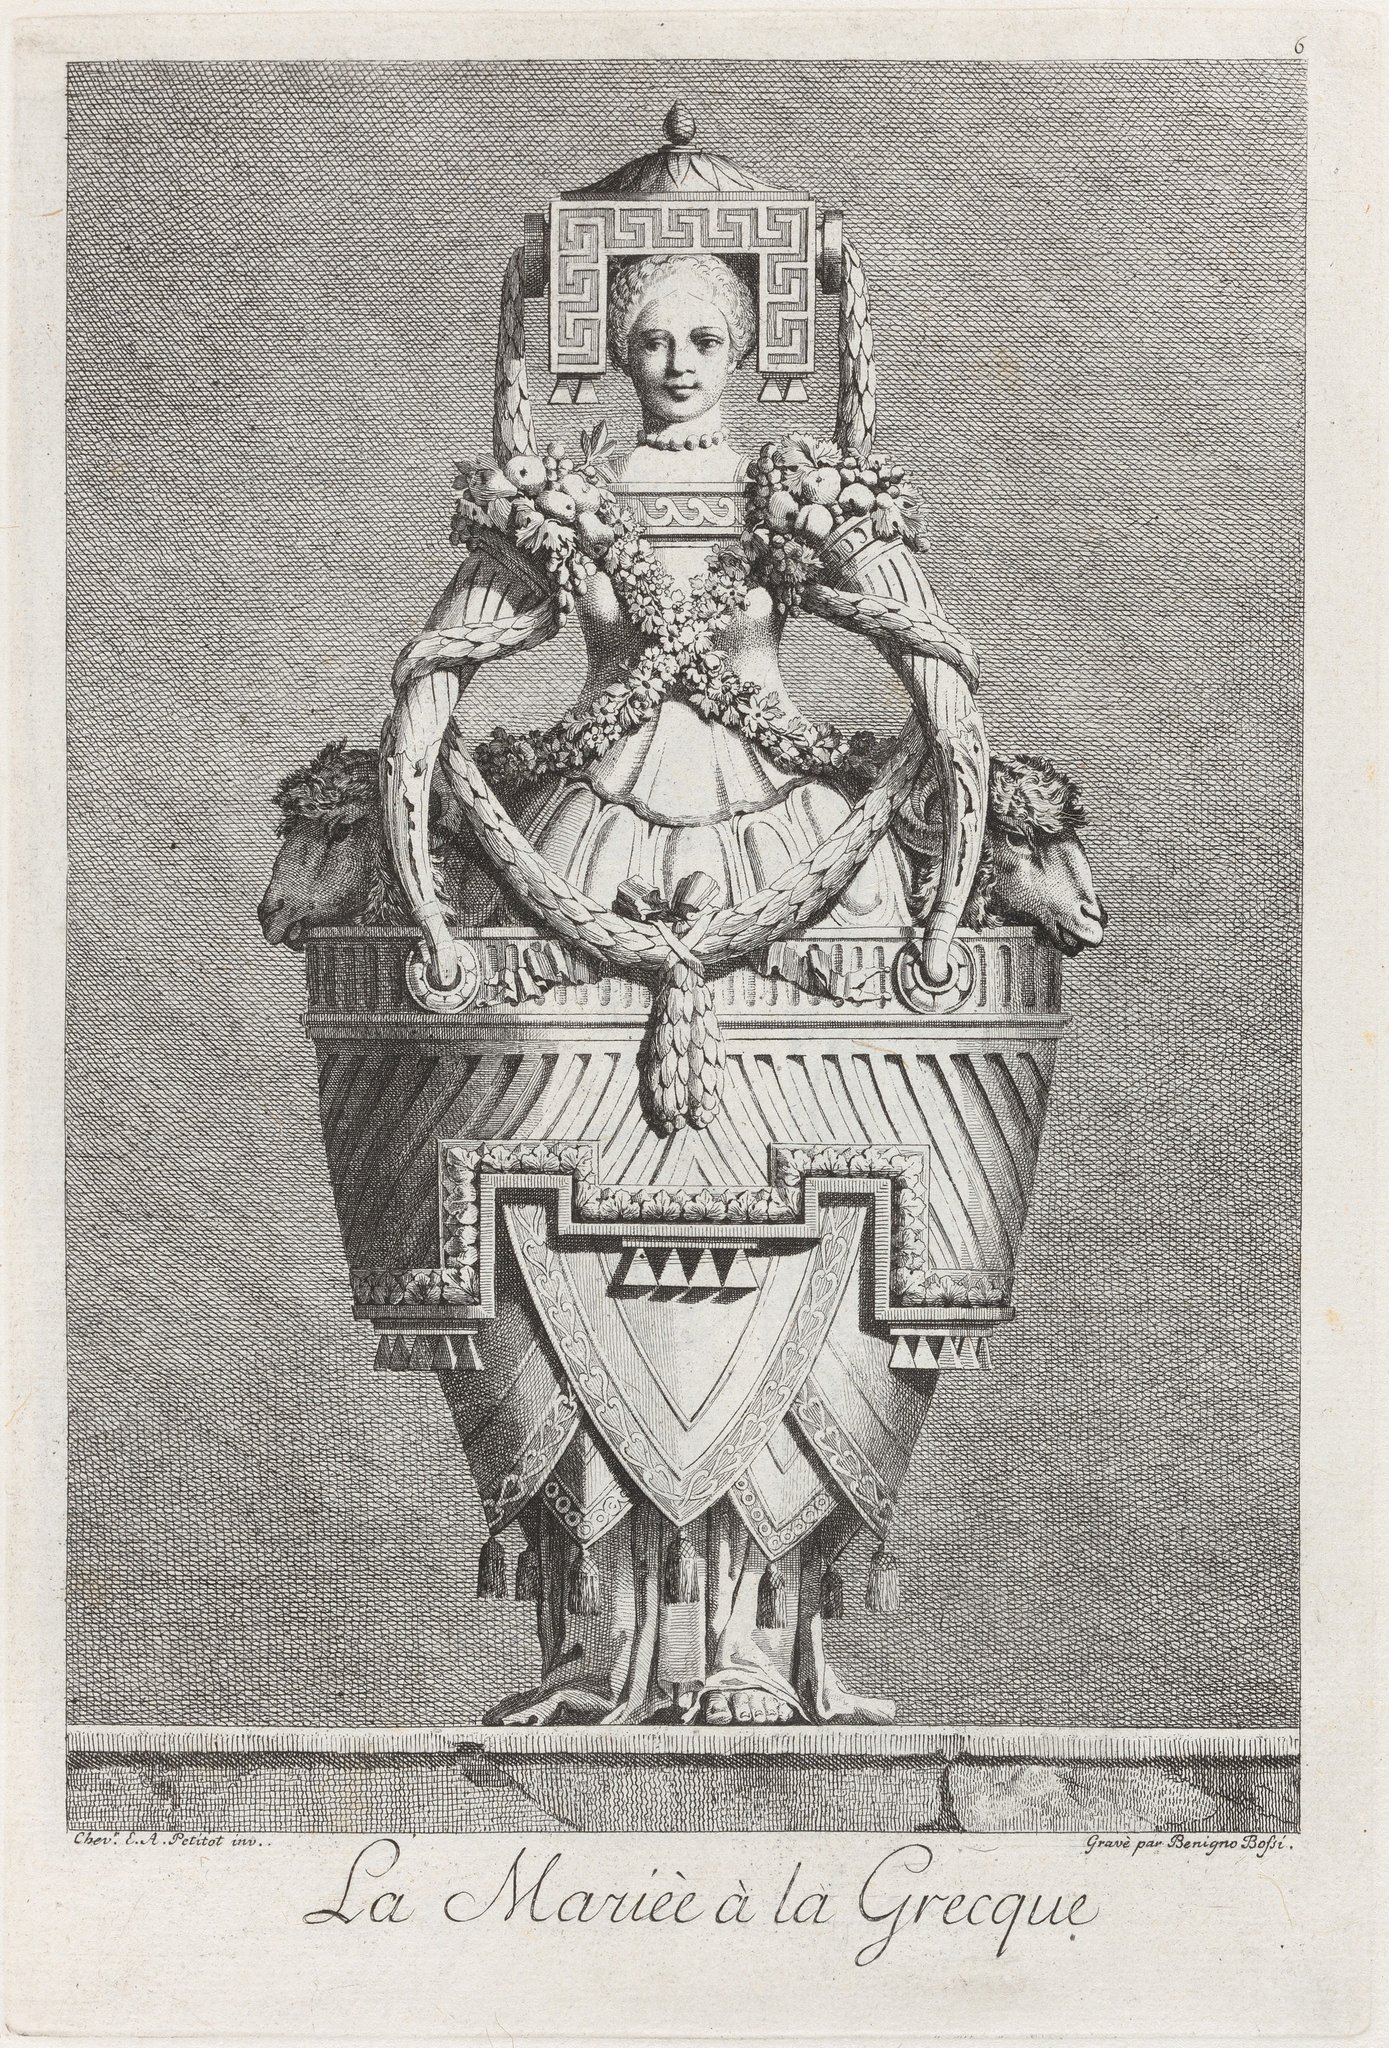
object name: book print ornament architecture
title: Mascarade à la Grecque; Suite des Vases; and [Cheminées]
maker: ennemond alexandre petitot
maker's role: artist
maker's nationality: french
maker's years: 1727-1801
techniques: etching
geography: italy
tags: garlands,women,cornucopia,vases